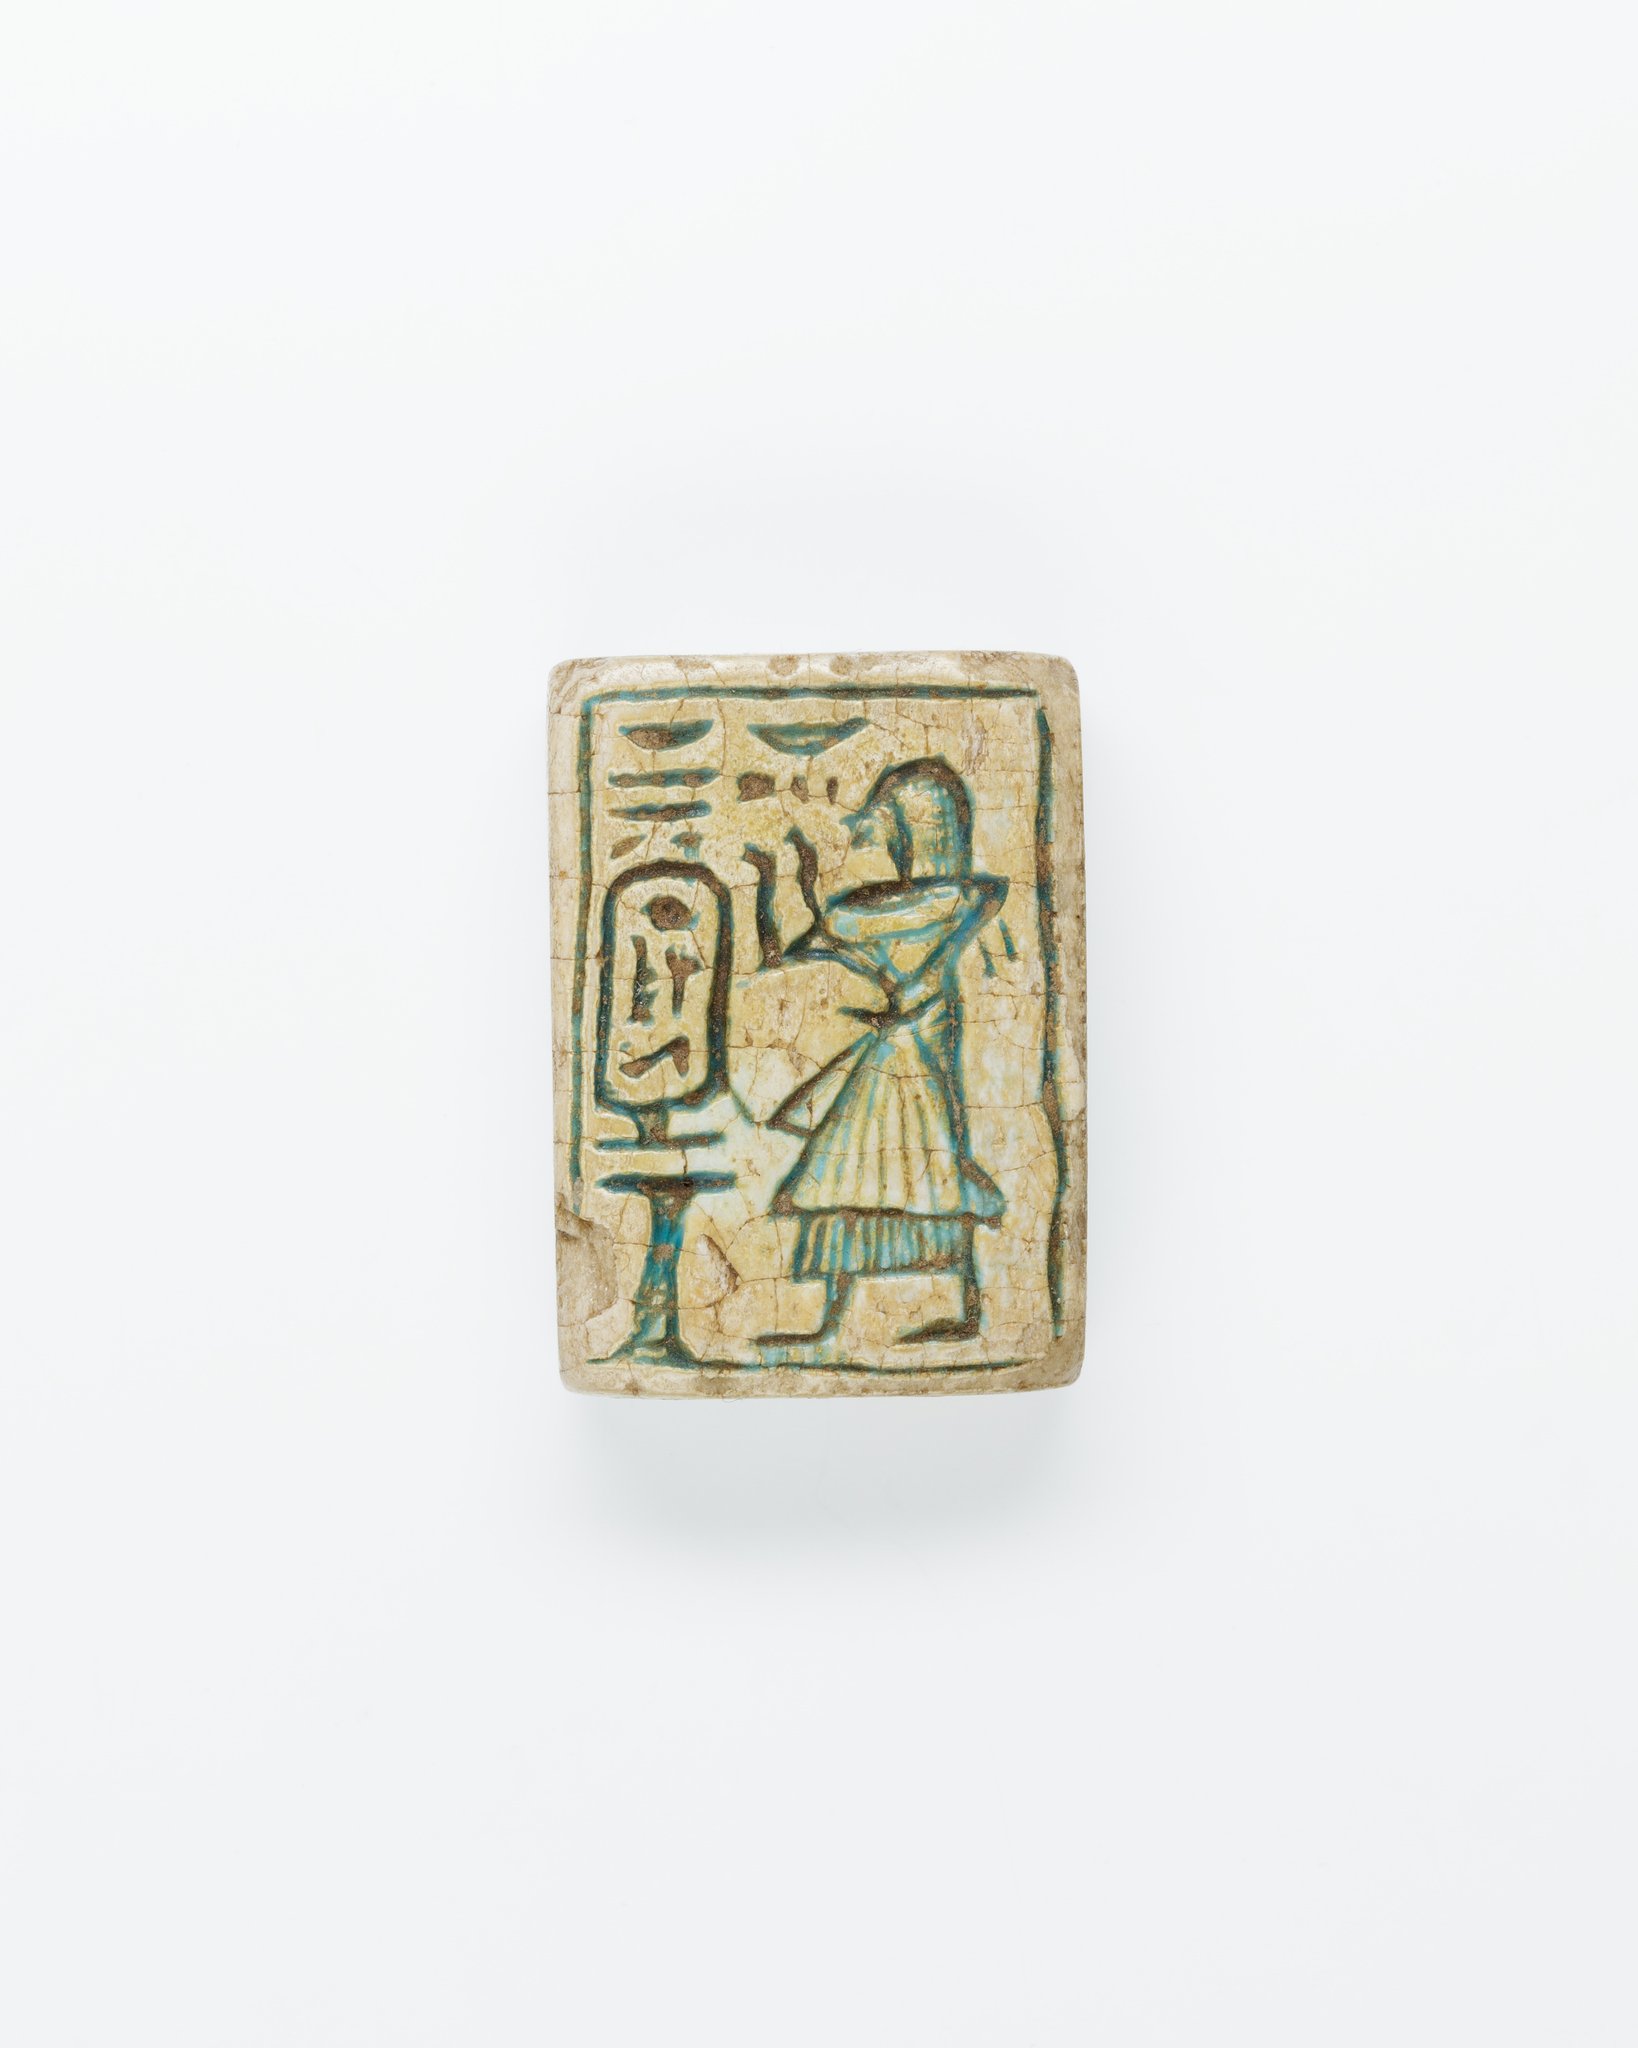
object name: plaque, paser, scribe of the granary of the divine offering of all the god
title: Bead Plaque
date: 1295-1185 BCE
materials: stone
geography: egypt